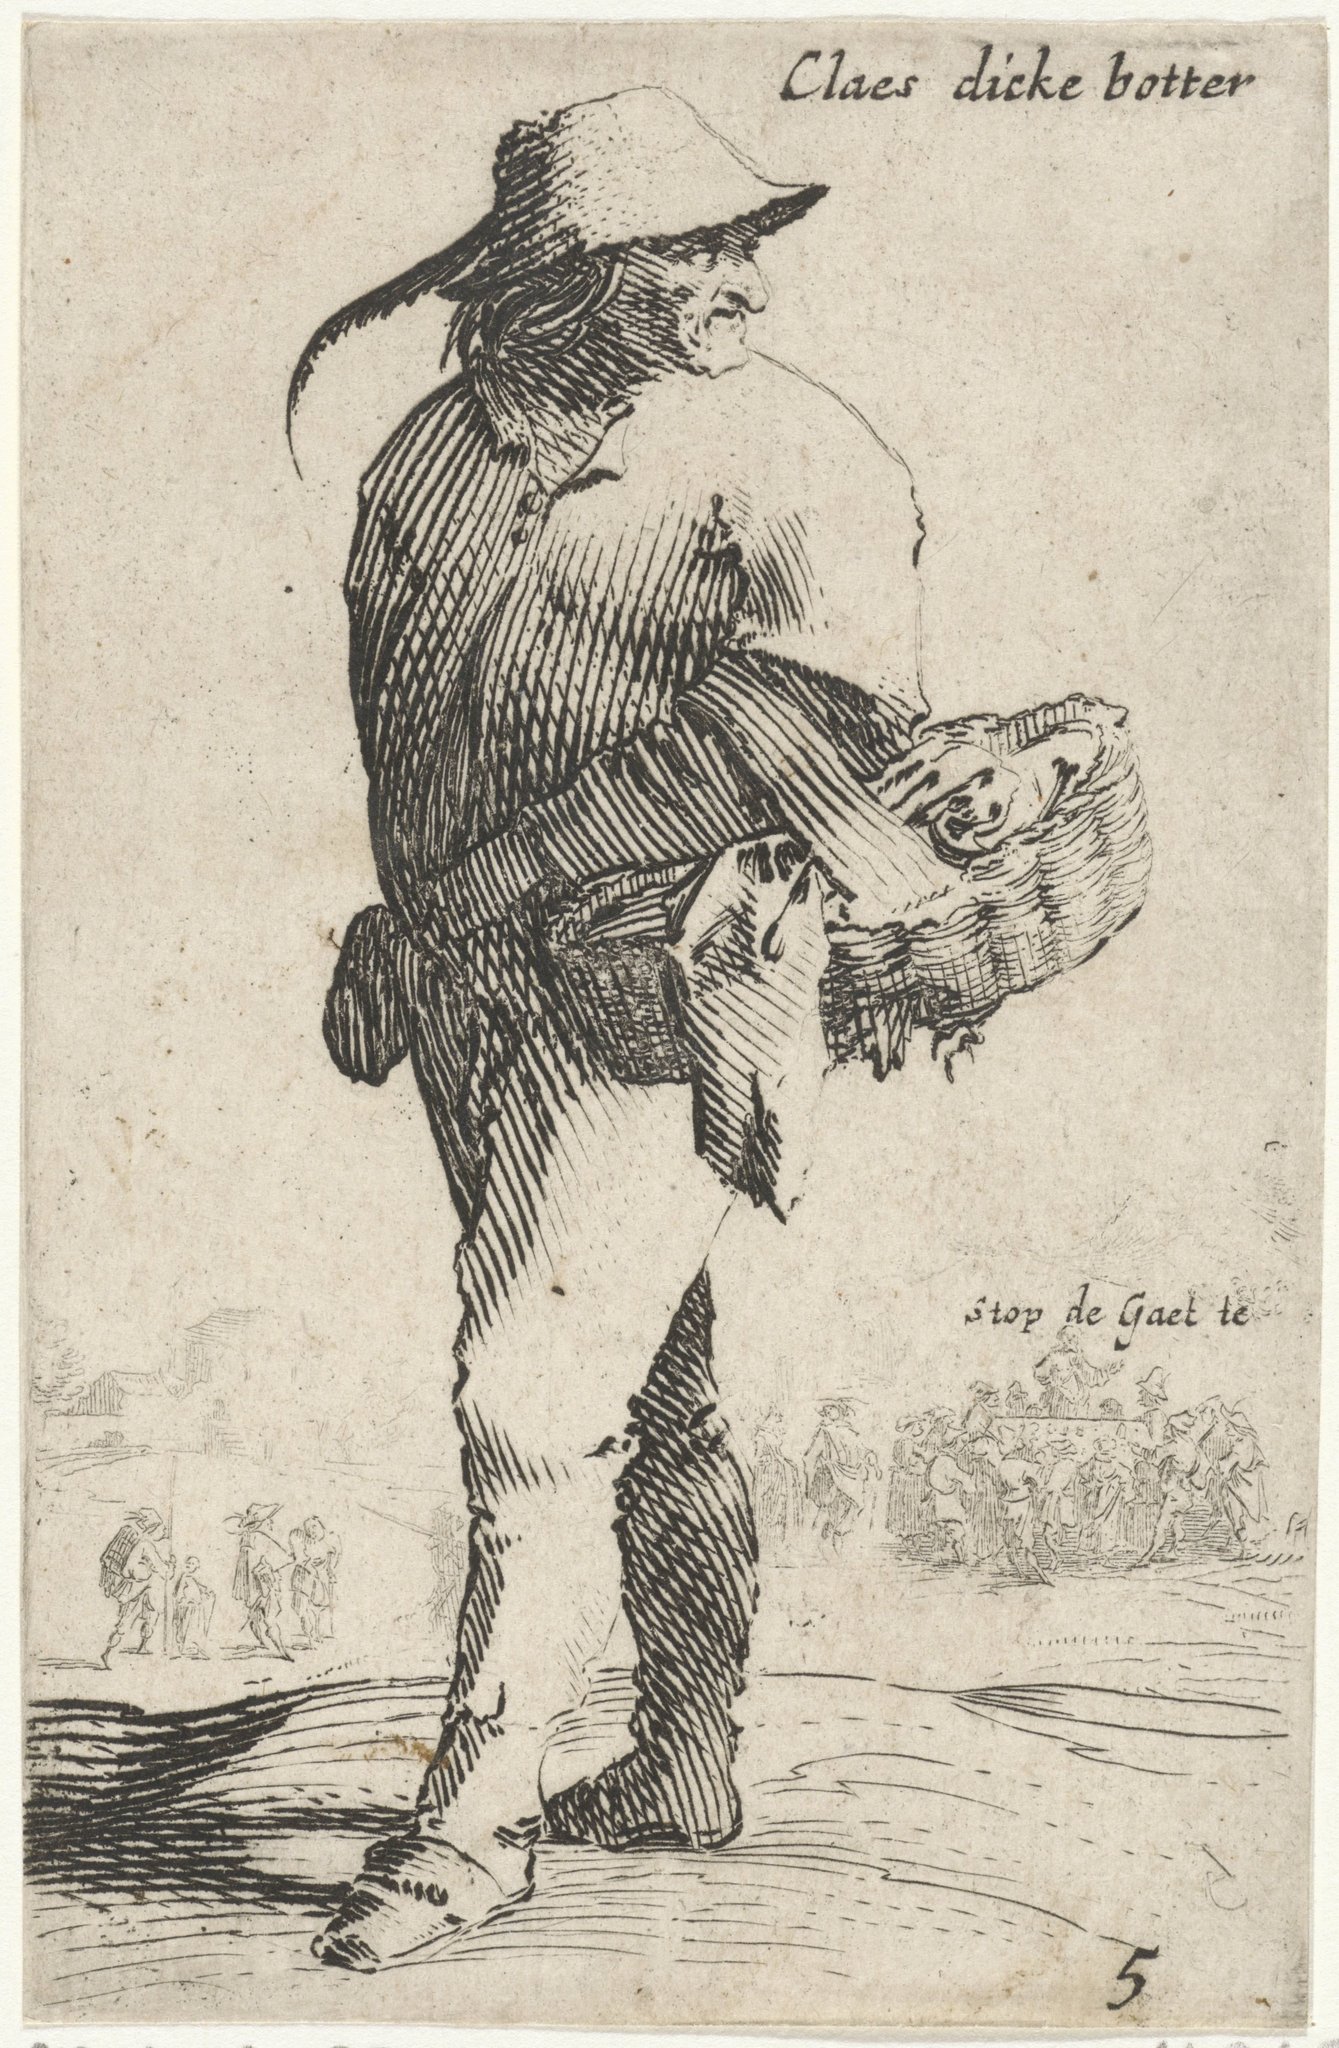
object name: print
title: T'Leven Der Boeren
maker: salomon savery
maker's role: print maker, publisher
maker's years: 1594-1683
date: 1630-1665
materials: paper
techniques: engraving, etching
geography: amsterdam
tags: farmers, carrying something in basket, bag, rucksack, etc.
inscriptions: collector's mark: Lugt 2228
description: De prent maakt deel uit van een twaalfdelige serie prenten met voorstellingen van boeren.